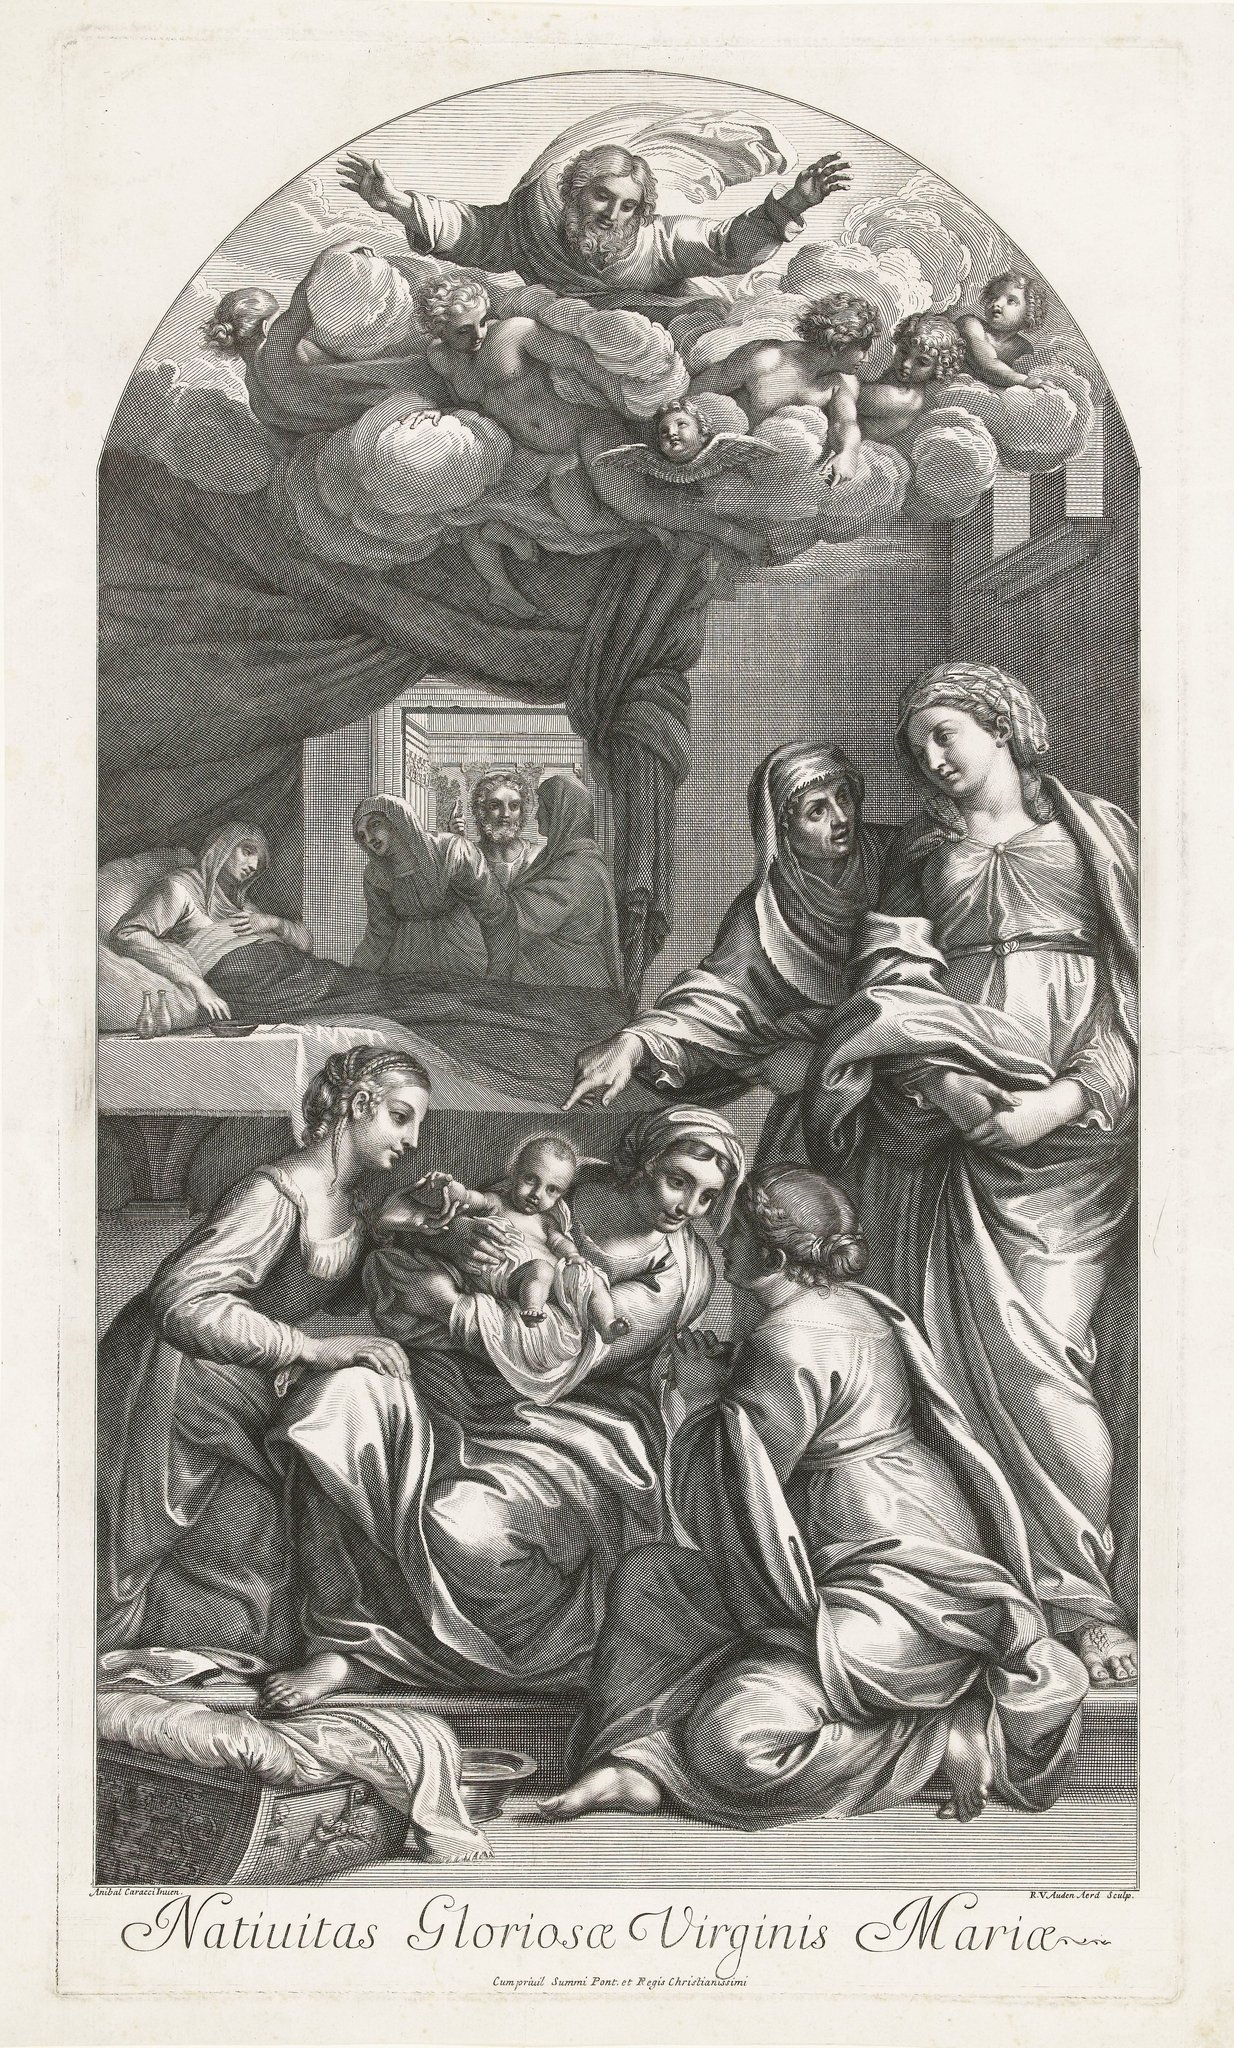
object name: print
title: Birth of the Virgin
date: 1685-1723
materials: paper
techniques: engraving, etching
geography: rome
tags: birth of mary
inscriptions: collector's mark: Lugt 240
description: De heilige Anna ligt na de bevalling van haar dochter Maria op bed. Vijf dienstmaagden bekommeren zich om het net geboren kindje. Een oudere maagd wijst naar het kind en vertelt een ander iets. In de deuropening van Annas kamer is Marias vader de heilige Joachim te zien. Vanuit de hemel kijkt God de Vader naar de gebeurtenis.